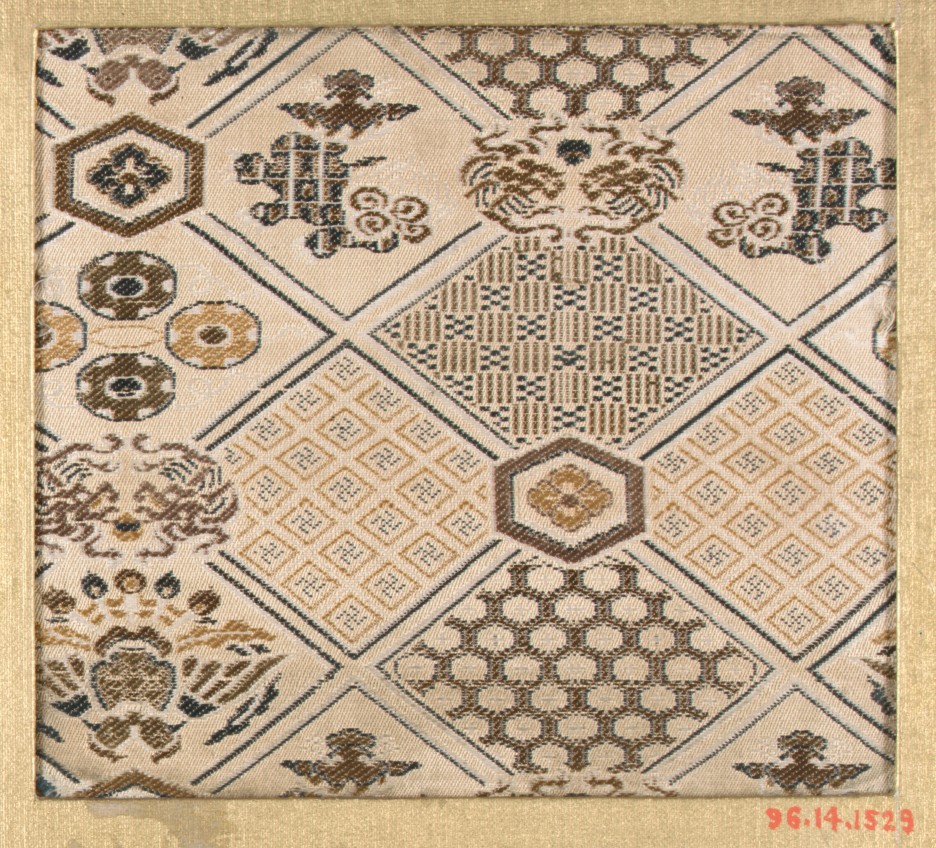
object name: piece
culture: japanese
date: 1701-1900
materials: silk